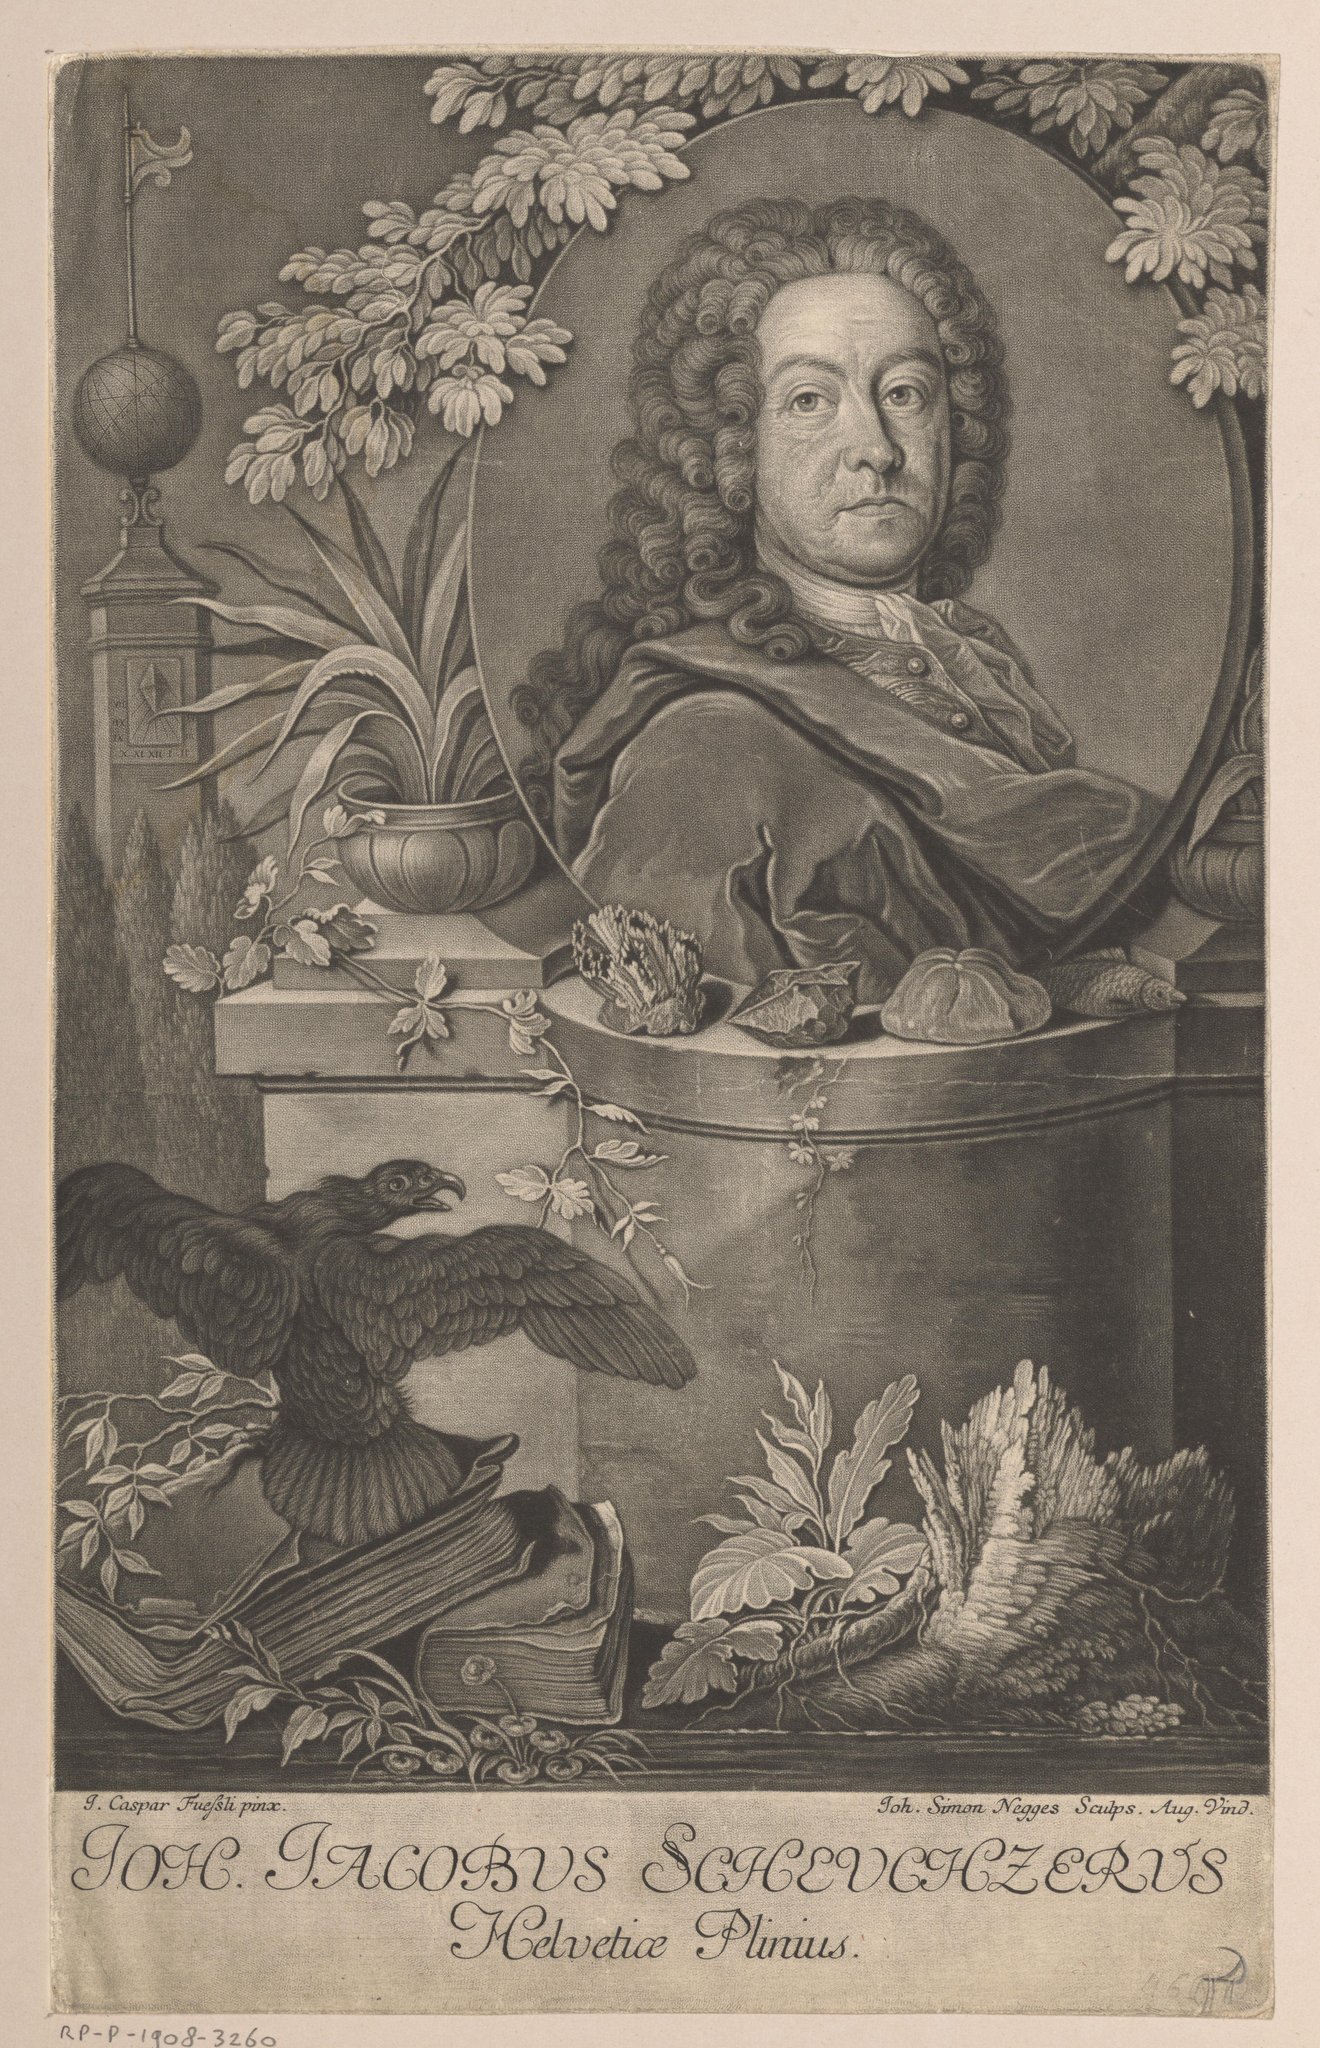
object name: print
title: Portret van Johann Jakob Scheuchzer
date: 1736-1792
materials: paper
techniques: engraving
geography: augsburg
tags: johann jakob scheuchzer, plants (in general), fossil plants, fossil animals, historical persons, physician, doctor, book, predatory birds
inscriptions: inscription: ‘D’, collector's mark: Lugt 2228